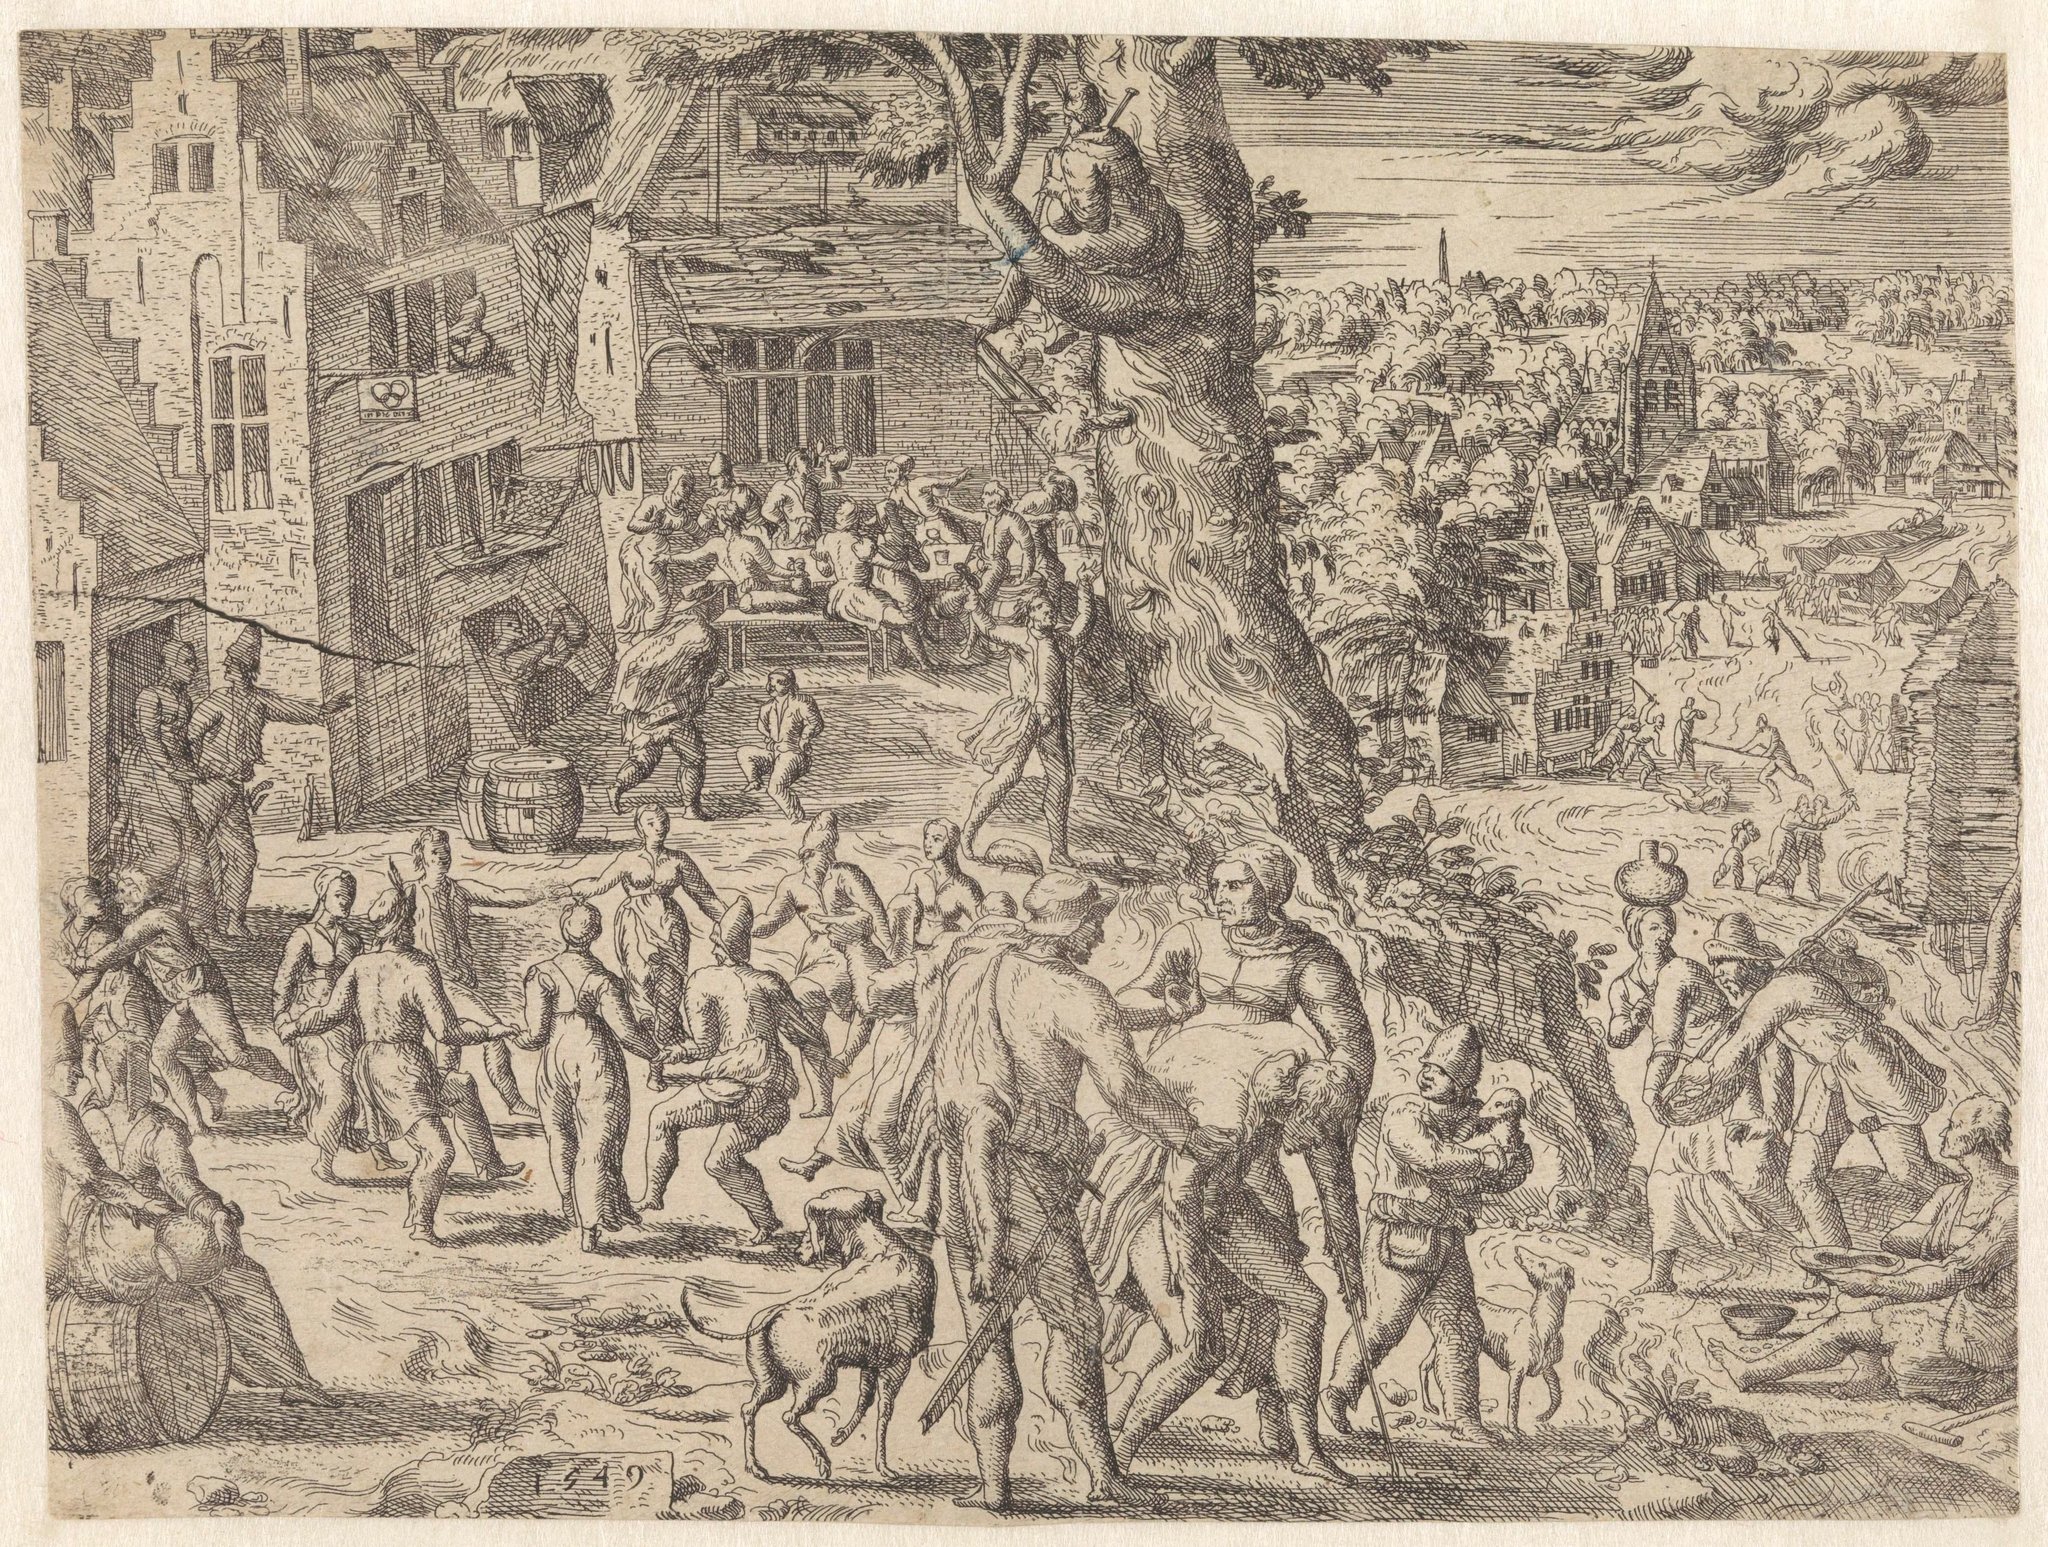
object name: print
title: Peasant Kermis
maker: pieter van der borcht (i)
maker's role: print maker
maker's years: 1545-1608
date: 1549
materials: paper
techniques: etching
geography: southern netherlands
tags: carousal, drinking-bout, orgy, (annual) fair, trade fair, folk dancing (men and women together), bagpipe, musette - cc - out of doors, pleasure fair and circus, drunken brawl (usually peasants fighting in an inn)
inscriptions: collector's mark: Lugt 2228, watermark: ‘kruik met klaverblad’, collector's mark: Lugt 1105b, collector's mark: Lugt 2760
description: Both painted and printed depictions of peasant fairs were popular until well into the 17th century. They are invariably packed with festive activities, including wild dancing, drinking, playing and making love. The consequences of dipsomania too are not omitted, with brawling and vomiting drunkards. This freely etched sheet from 1549, only two impressions of which are known, is one of the earliest examples.